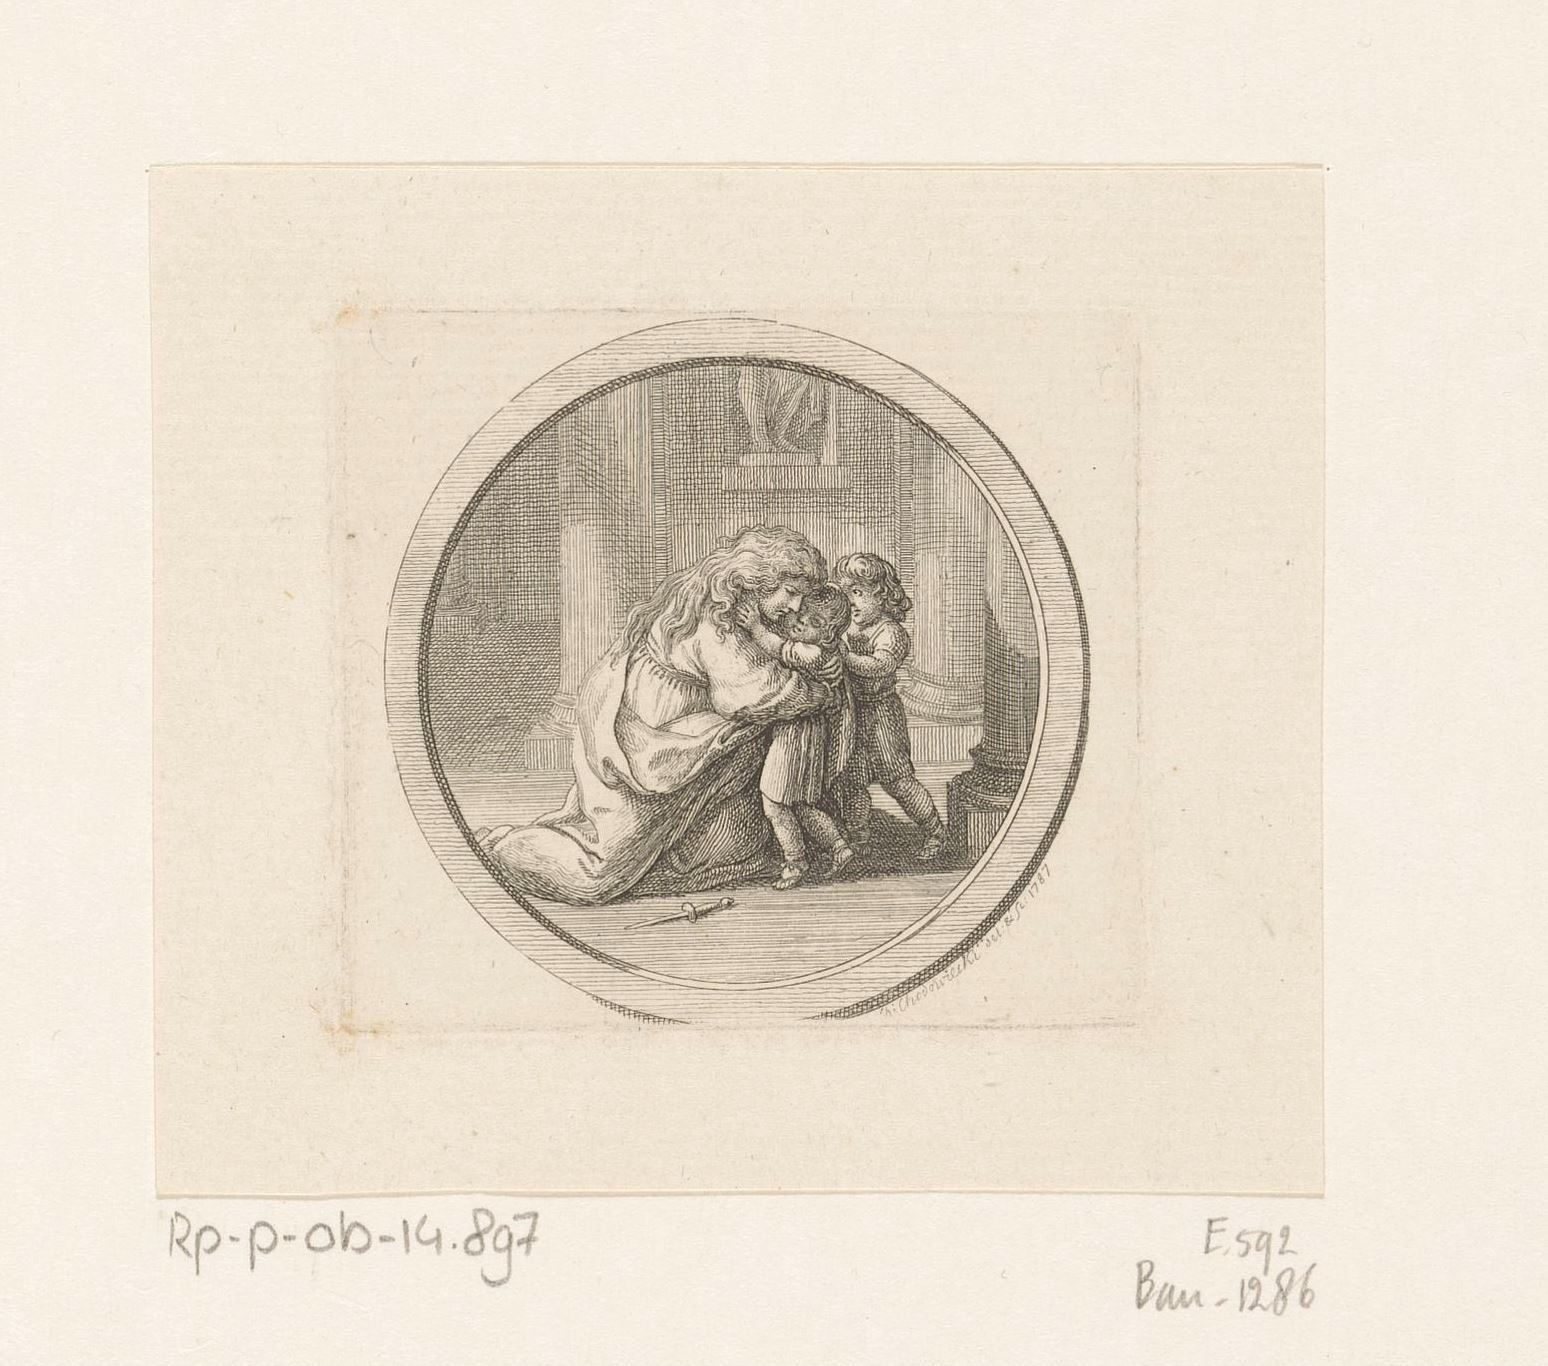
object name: print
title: Medea omhelst haar kinderen, waarna ze hen met een dolk doodt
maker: daniel nikolaus chodowiecki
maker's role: draughtsman, print maker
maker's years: 1726-1801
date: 1787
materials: paper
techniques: etching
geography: berlin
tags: literature, hacking and thrusting weapons: dagger, medea, embracing each other, kissing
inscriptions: collector's mark: Lugt 2228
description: Vervaardigd voor Gotter's vertelling 'Medea, ein Melodrama'. Prent uit: Gedichte von Friedrich Wilhelm Gotter. Gotha bei Carl: Wilhelm Ettinger, 1788, dl. 2.